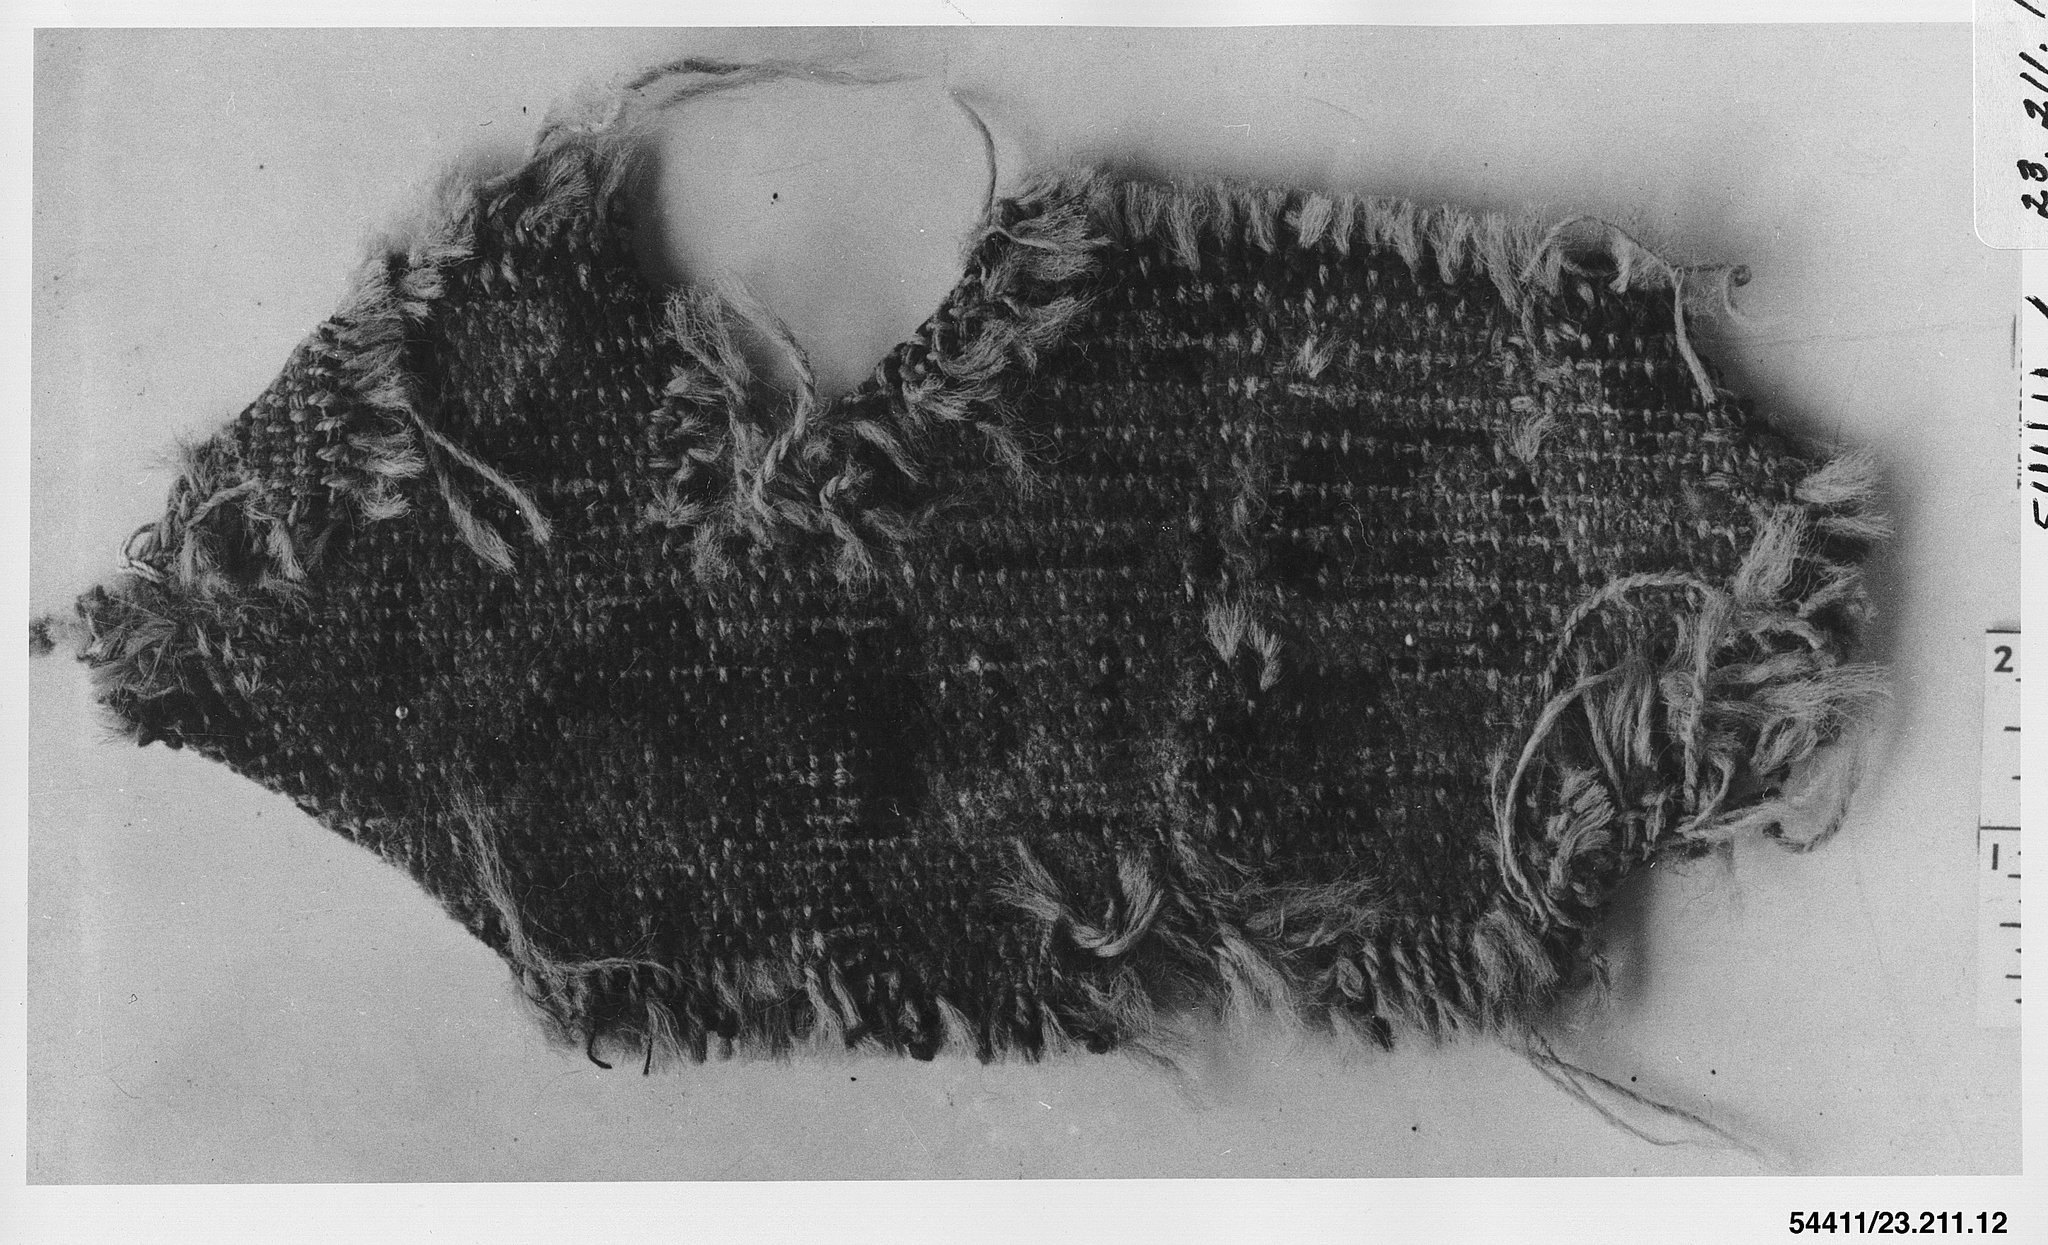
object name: rug fragment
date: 1501-1600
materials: wool